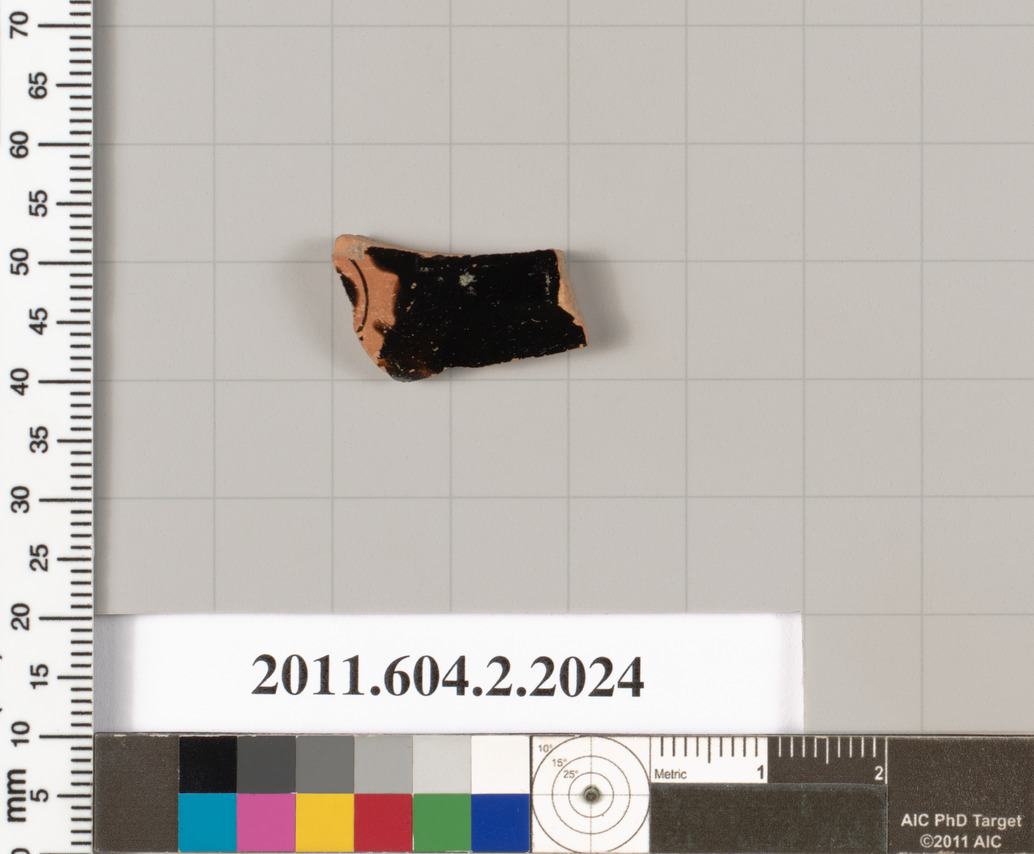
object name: askos fragment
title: Terracotta fragment of an askos (flask with a spout and handle over the top)?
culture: greek, attic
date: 425-401 BCE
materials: terracotta